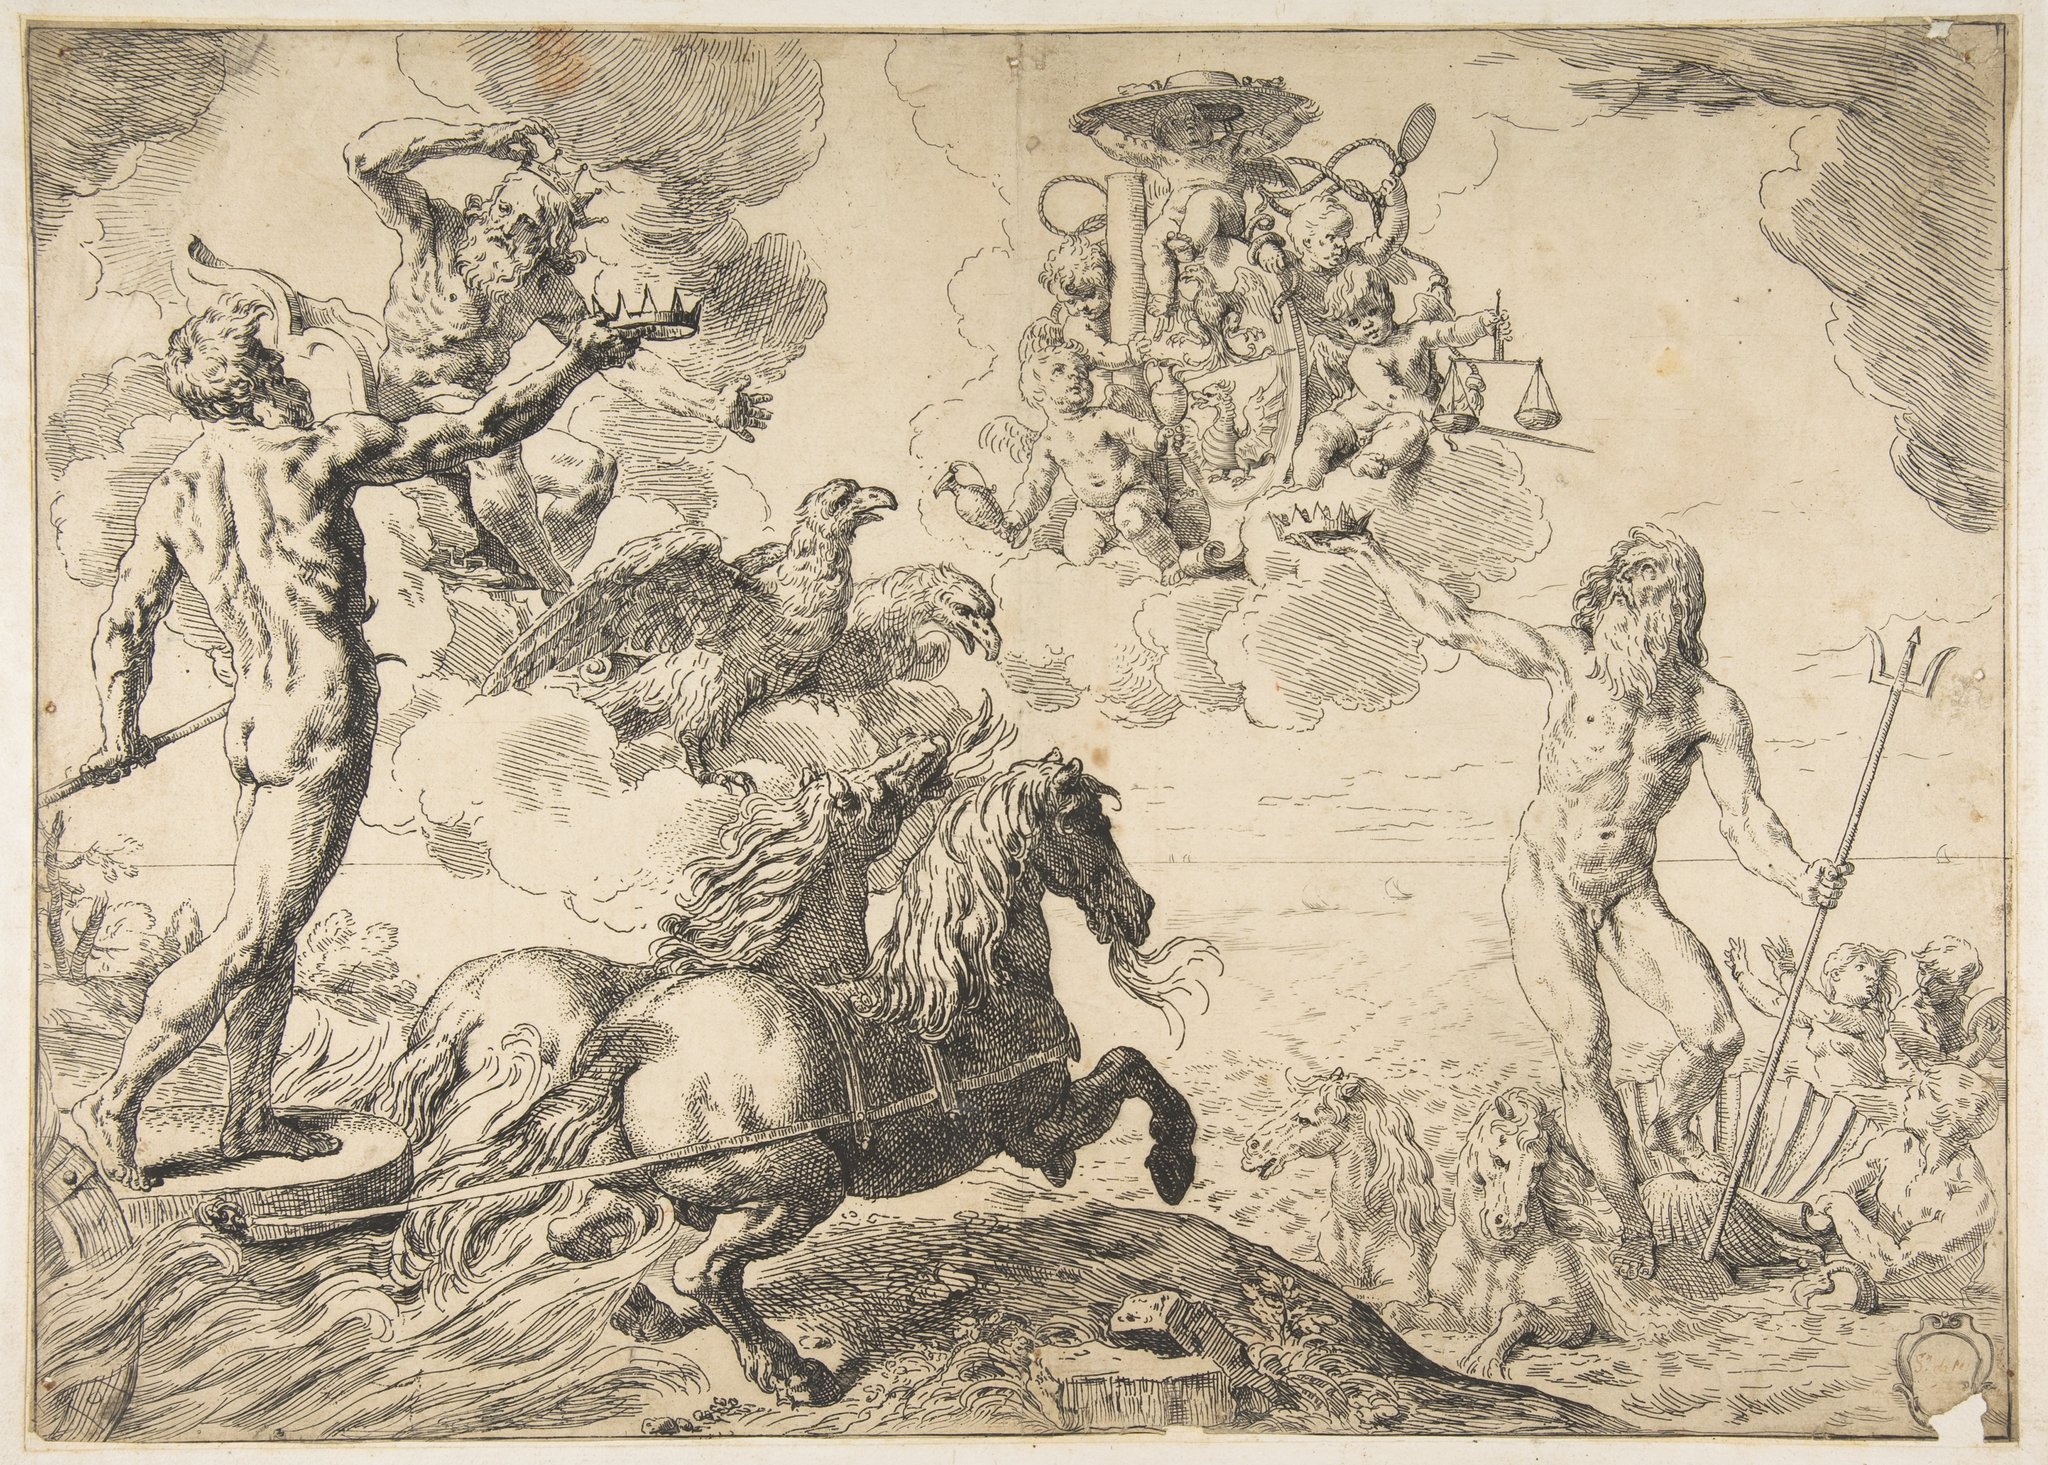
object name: print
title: Jupiter, Neptune, and Pluto offering their crowns to the arms of Cardinal Borghese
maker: simone cantarini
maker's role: artist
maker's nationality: italian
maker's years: 1612-1648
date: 1642-1643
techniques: etching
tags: eagles,jupiter,neptune,horses,pluto